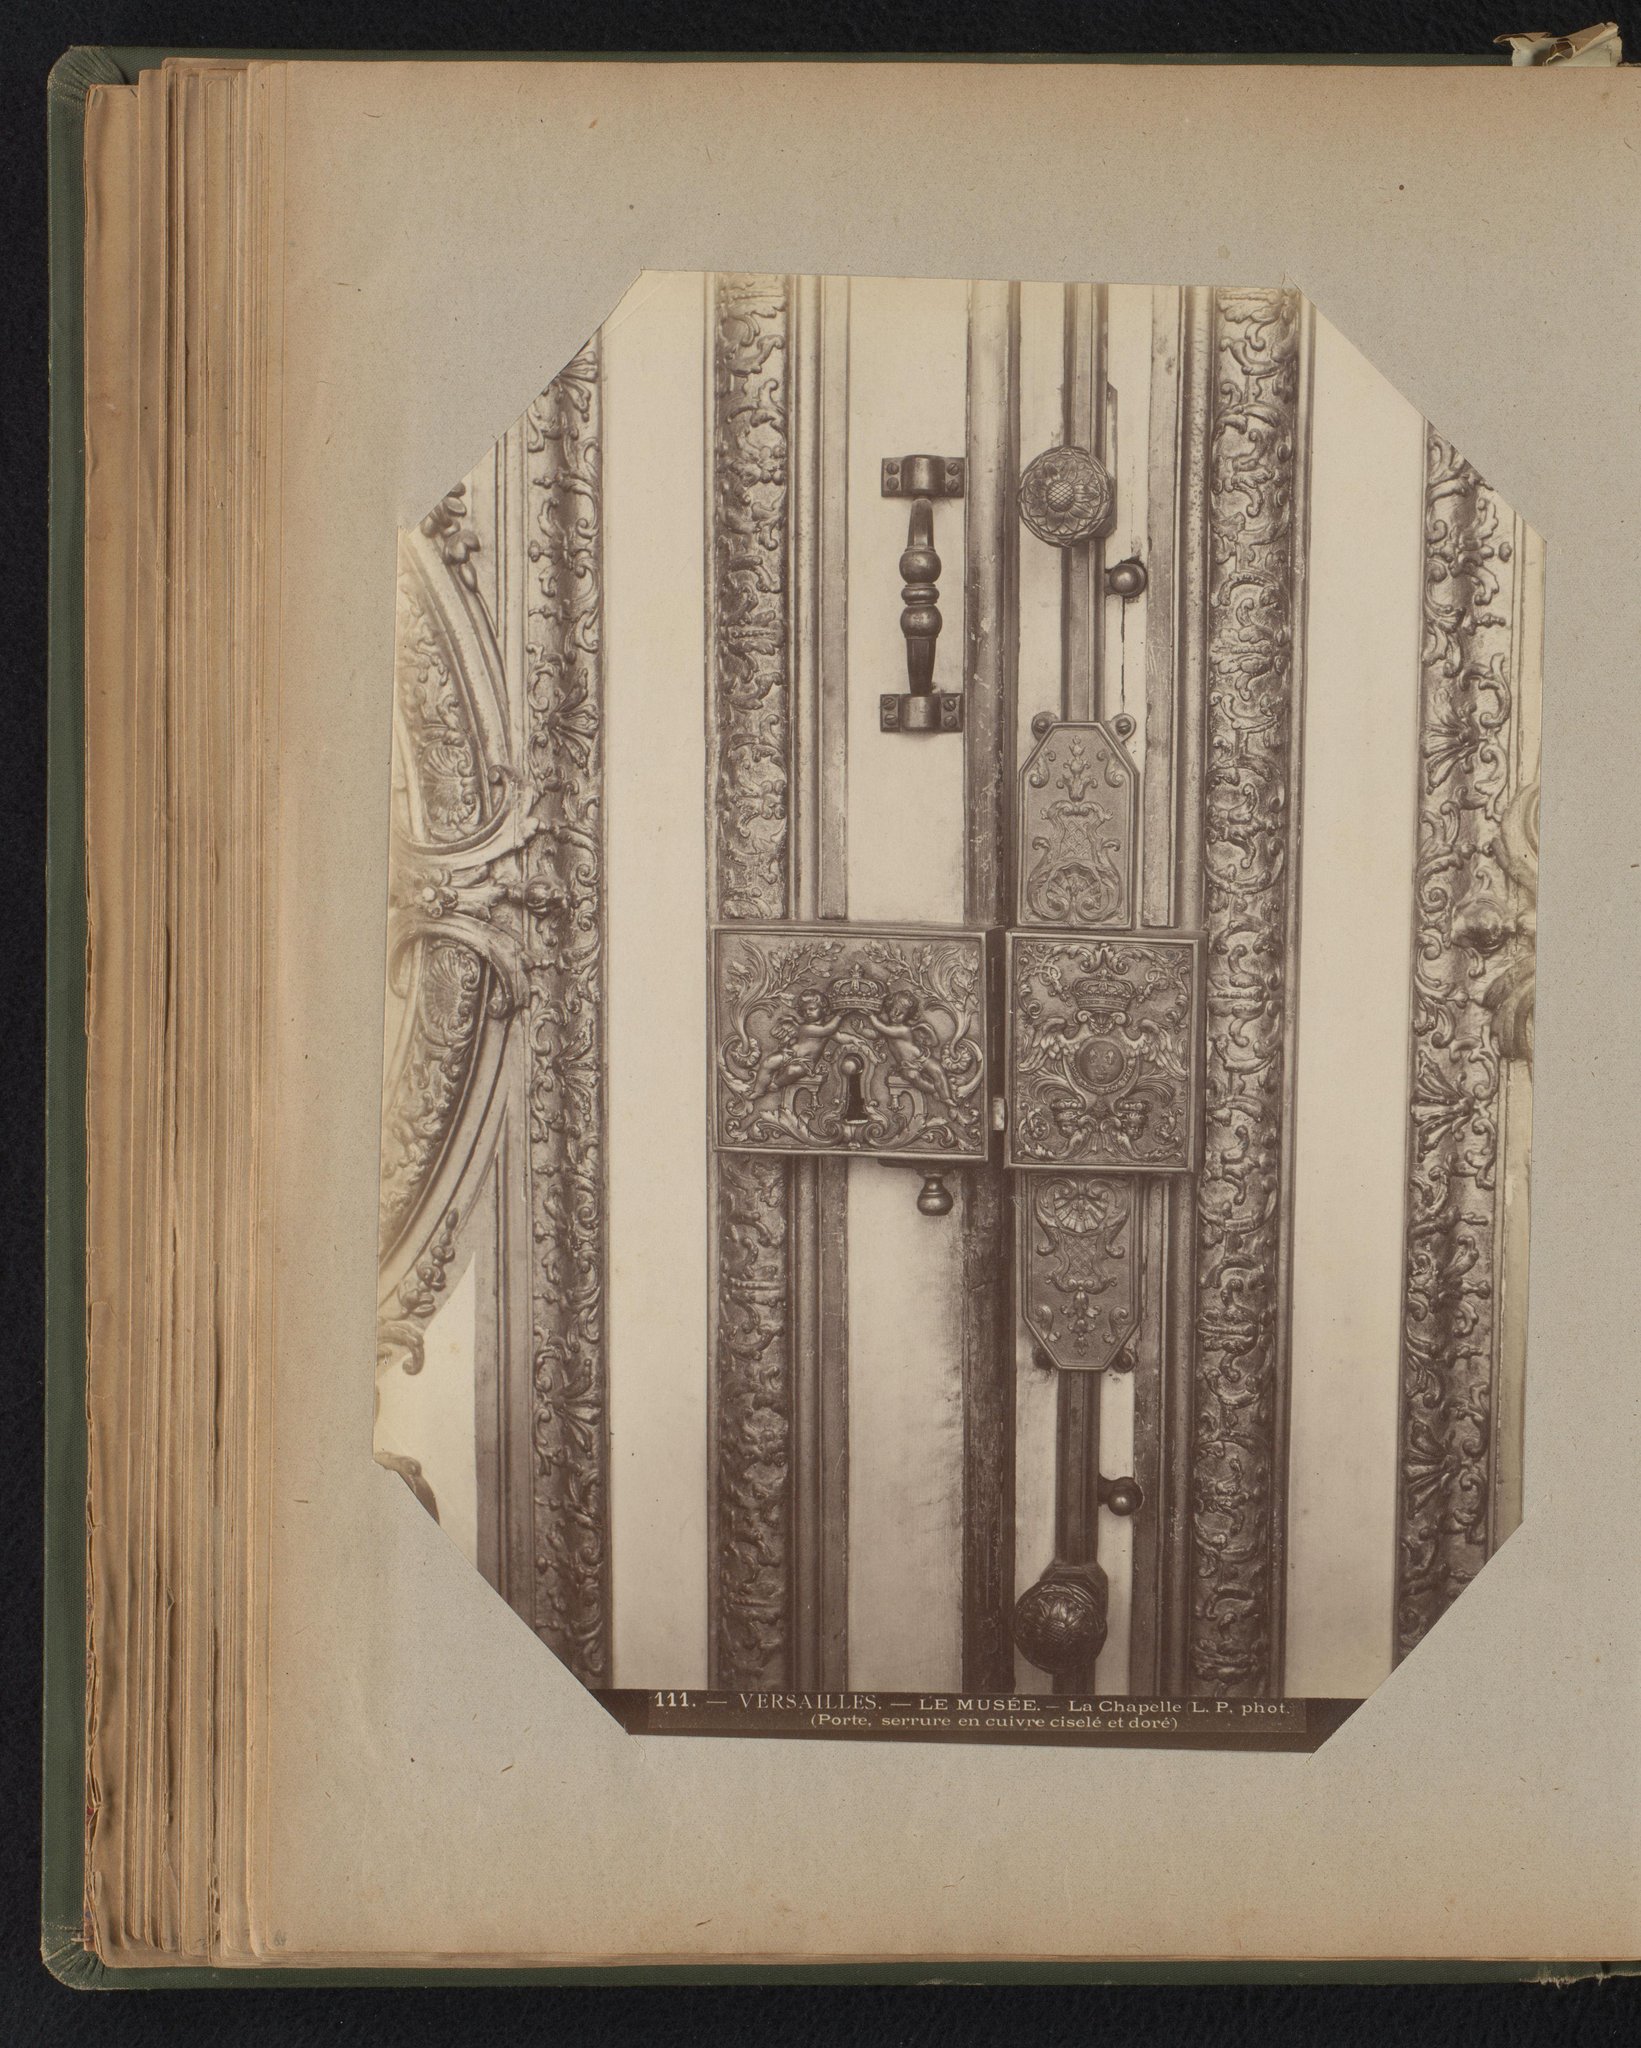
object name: photograph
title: Slot van het hek gedecoreerd engelen die in hun handen een kroon dragen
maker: Anonymous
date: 1860-1900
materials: paper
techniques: albumen print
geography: france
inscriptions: annotation: ‘111 - Versailles Le Musee - La Chapelle (L.P. Phot) (Porte, serrure en cuivre cisele et doré).’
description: Het andere deel van het slot bevat een wapen met Franse lelies en vleugels. Onderdeel van een serie met betrekking tot het interieur van het paleis van Versailles met kroonluchters, deuren, portalen en meubelstukken.